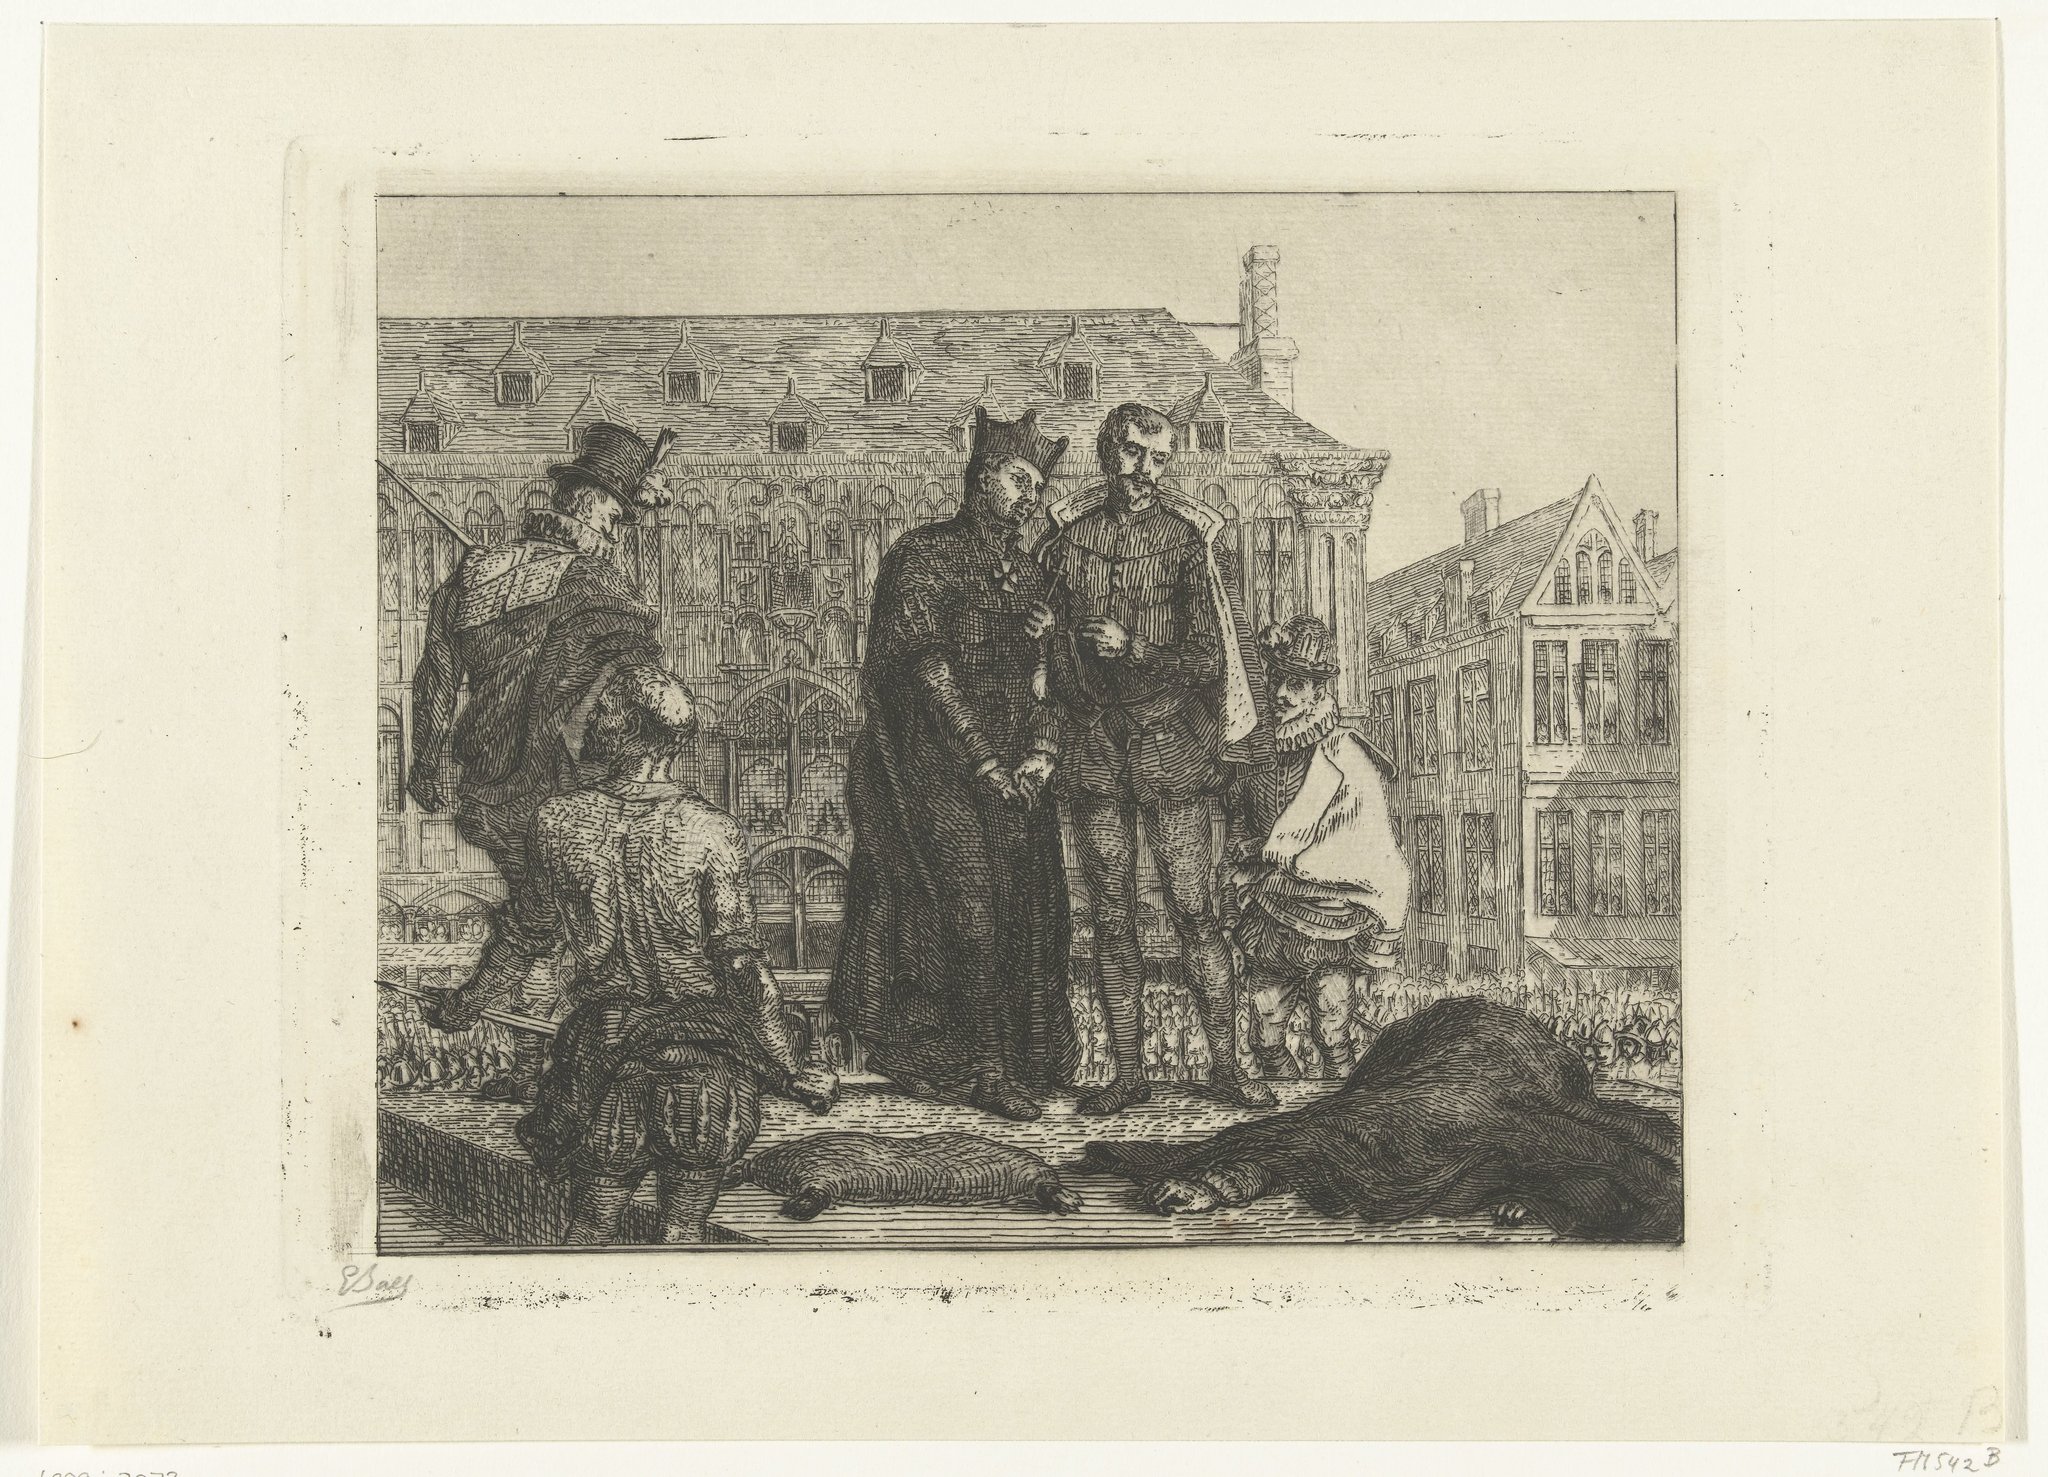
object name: history print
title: Egmond op het schavot, 1568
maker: edgar alfred baes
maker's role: print maker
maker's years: 1837-1909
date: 1847-1909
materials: paper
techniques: etching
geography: belgium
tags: brussels, earl, on the scaffold or place of execution, violent death by beheading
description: De graaf van Egmond op het schavot kijkt naar het lichaam van de graaf van Horne onder een kleed. Naast hem een priester, links de beul.